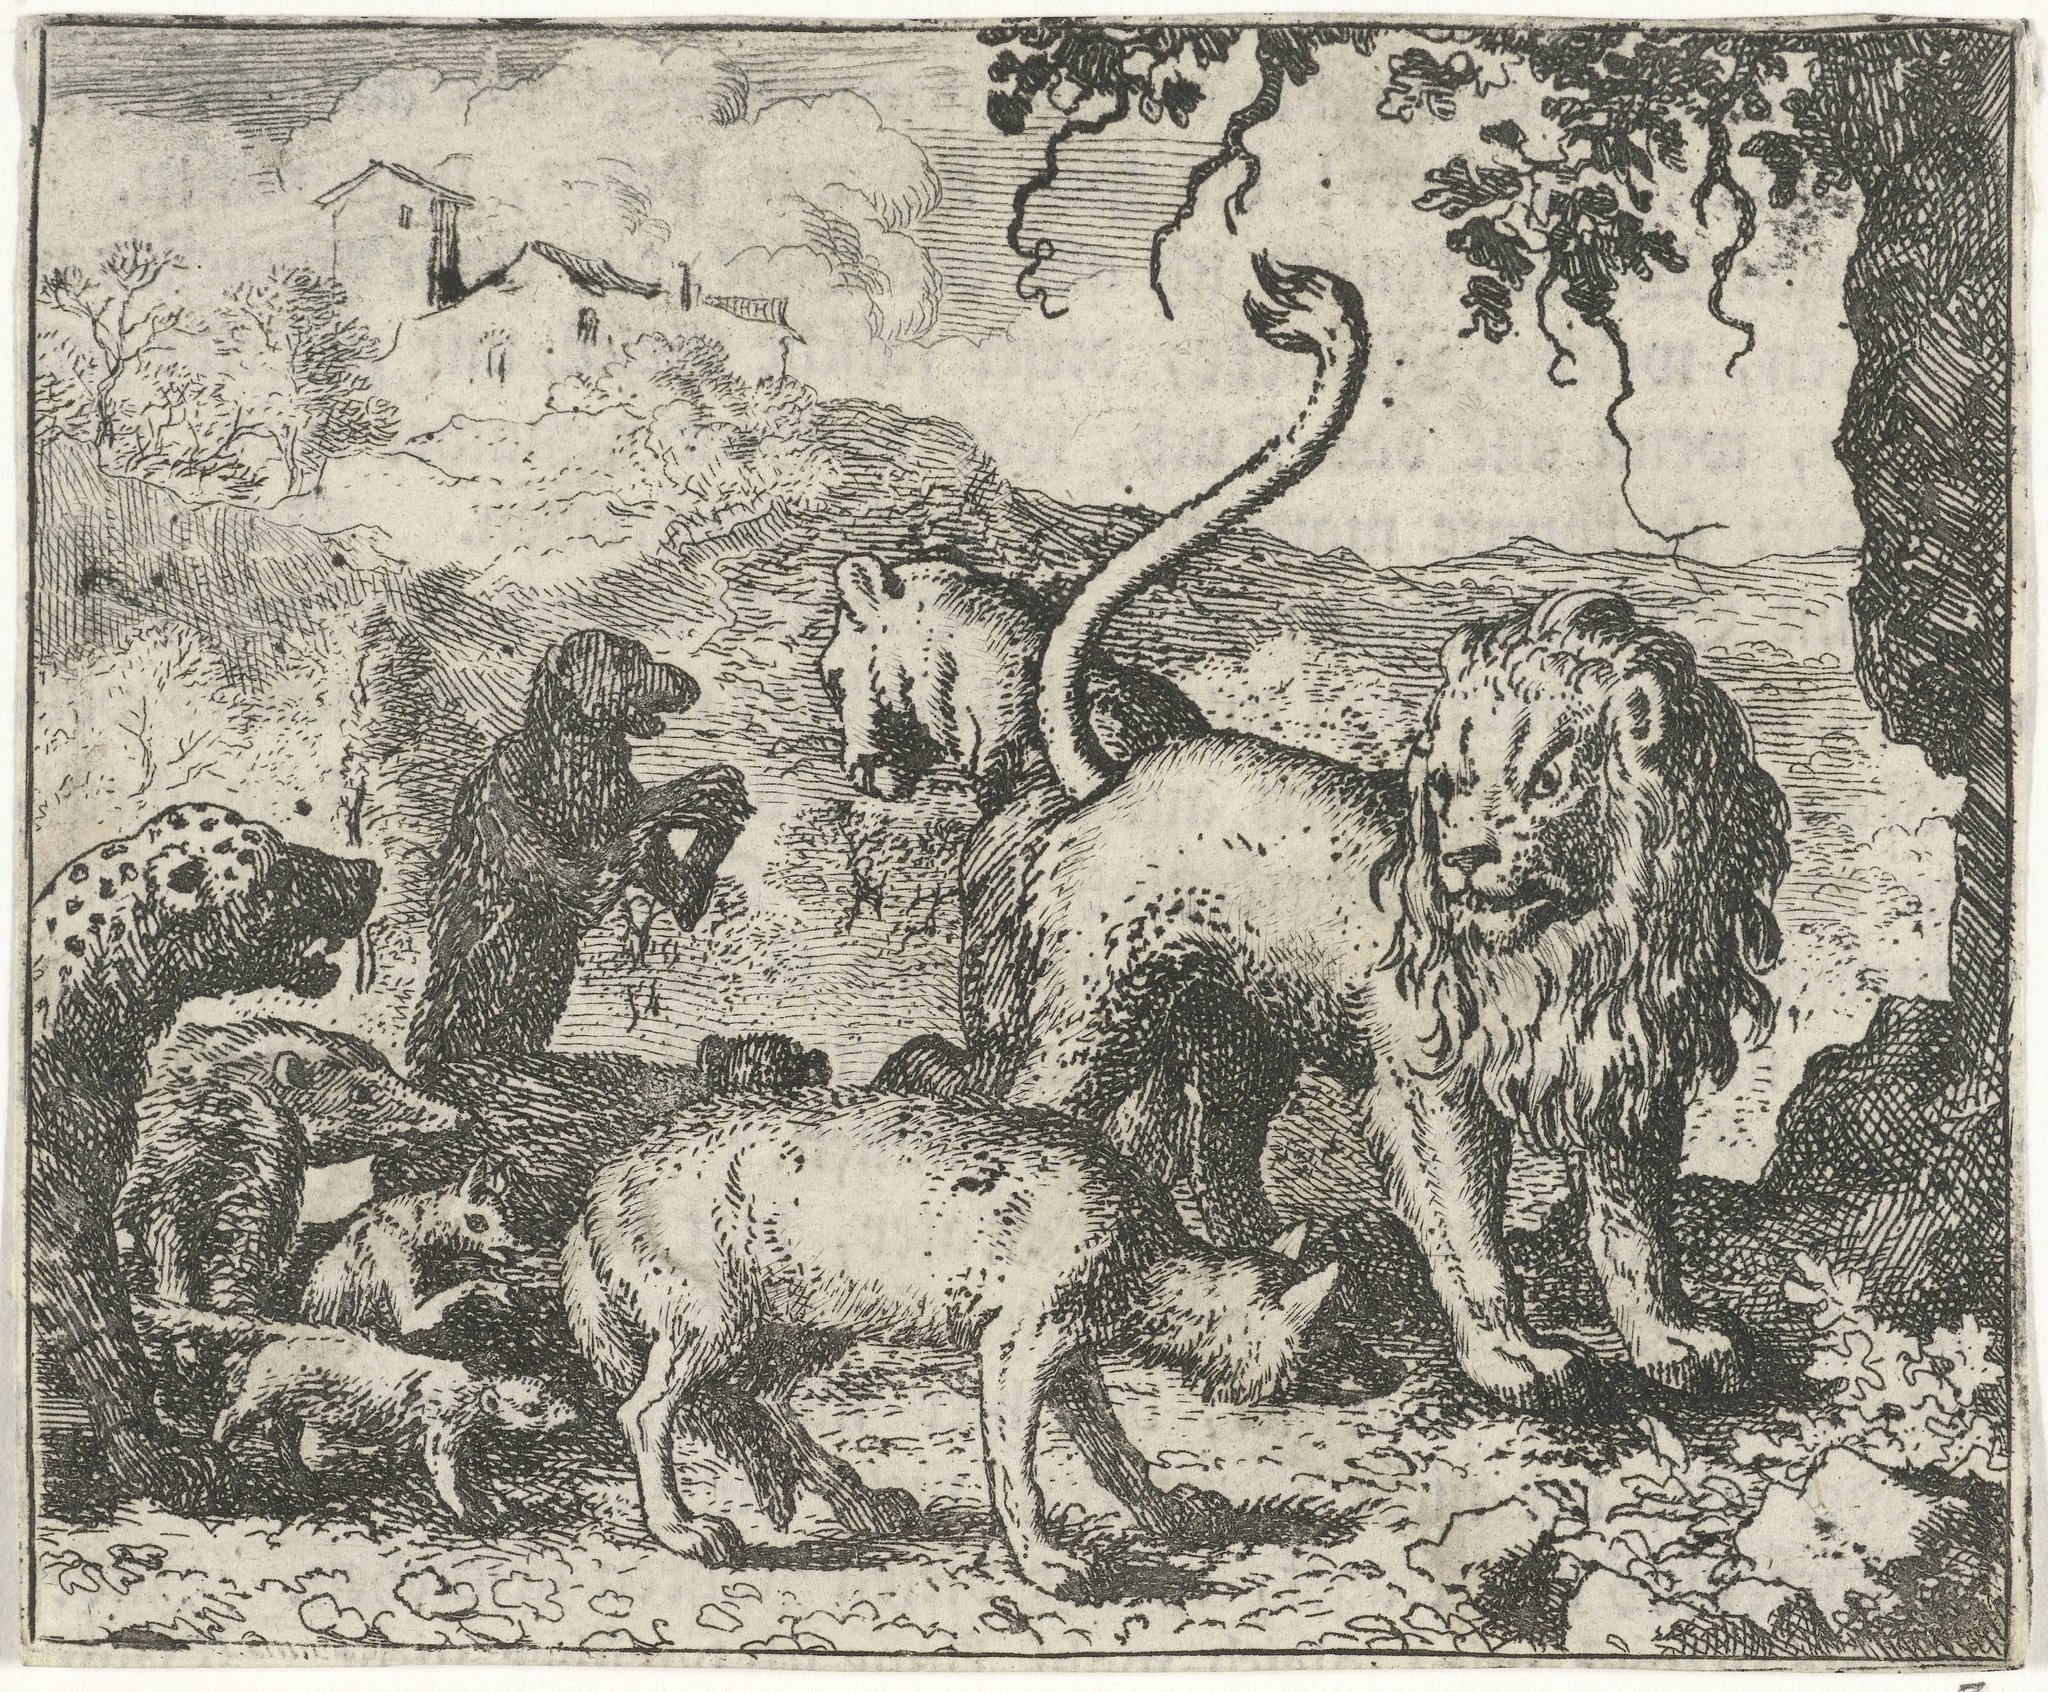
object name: book illustration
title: Beklag van Isengrijn de wolf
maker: allaert van everdingen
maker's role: draughtsman, painter, print maker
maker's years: 1621-1675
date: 1665-1675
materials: paper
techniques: etching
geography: netherlands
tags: fable of reynard the fox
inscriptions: collector's mark: Lugt 2228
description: Een groep dieren, waaronder de leeuw, koning Nobel en op de voorgrond de beschuldigde Reinaert de vos. Op de achtergrond doet Isengrijn de wolf zijn beklag. Op de achterkant van de prent een Duits tekstfragment uit het verhaal van Reinaert de vos.